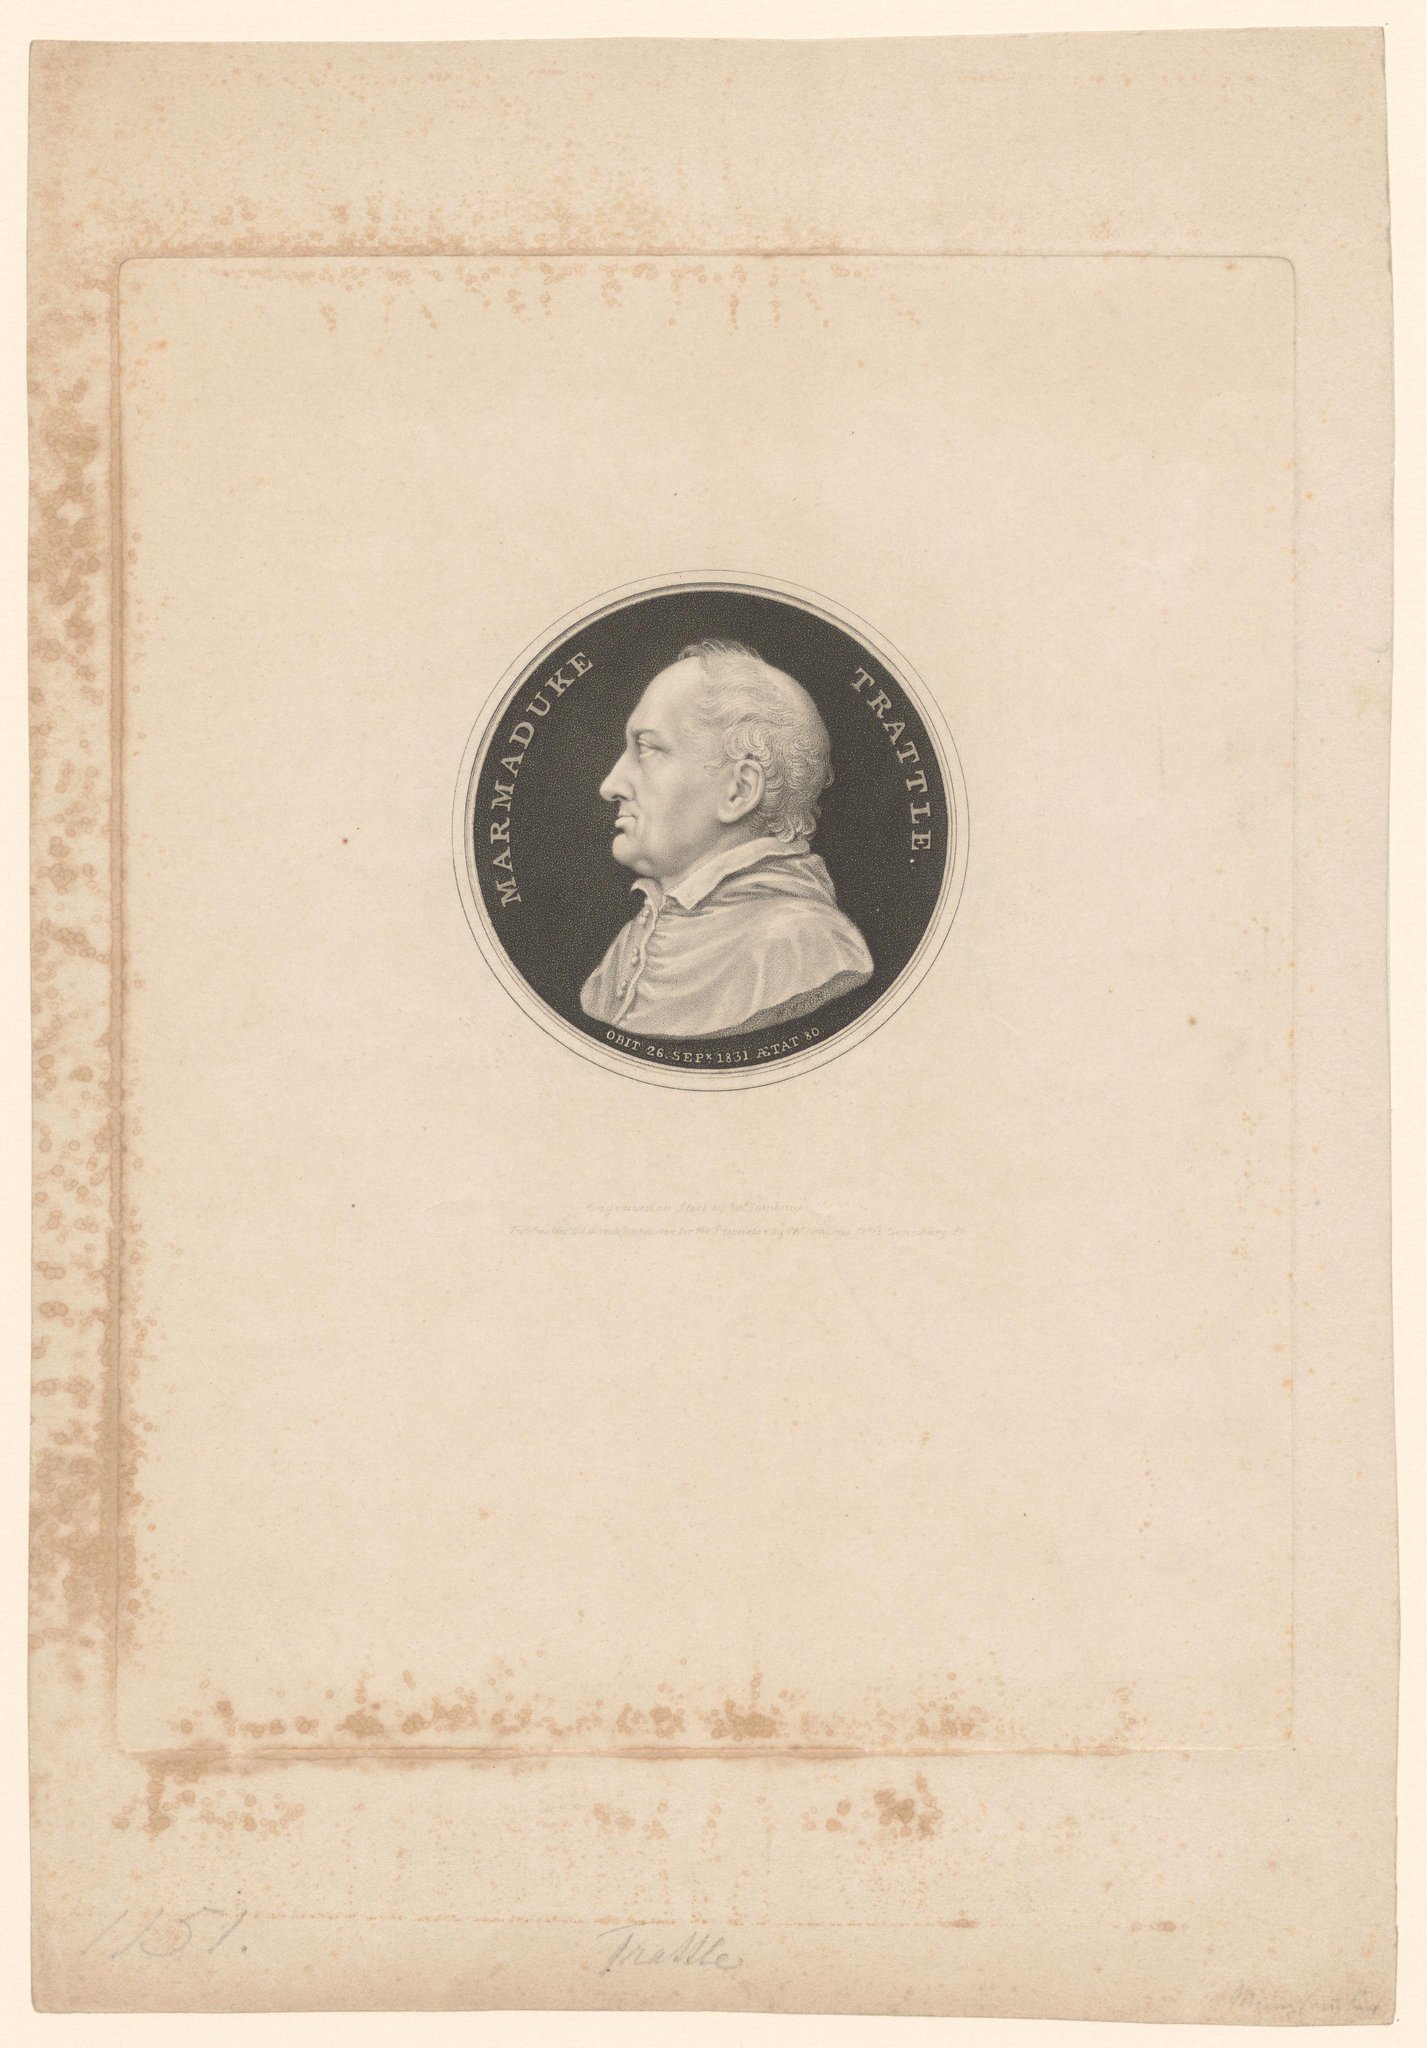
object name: print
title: Portret van Marmaduke Trattle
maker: peltro william tomkins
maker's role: print maker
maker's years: 1760-1840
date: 1801-1832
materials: paper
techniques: engraving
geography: london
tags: historical persons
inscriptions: collector's mark: Lugt 2228